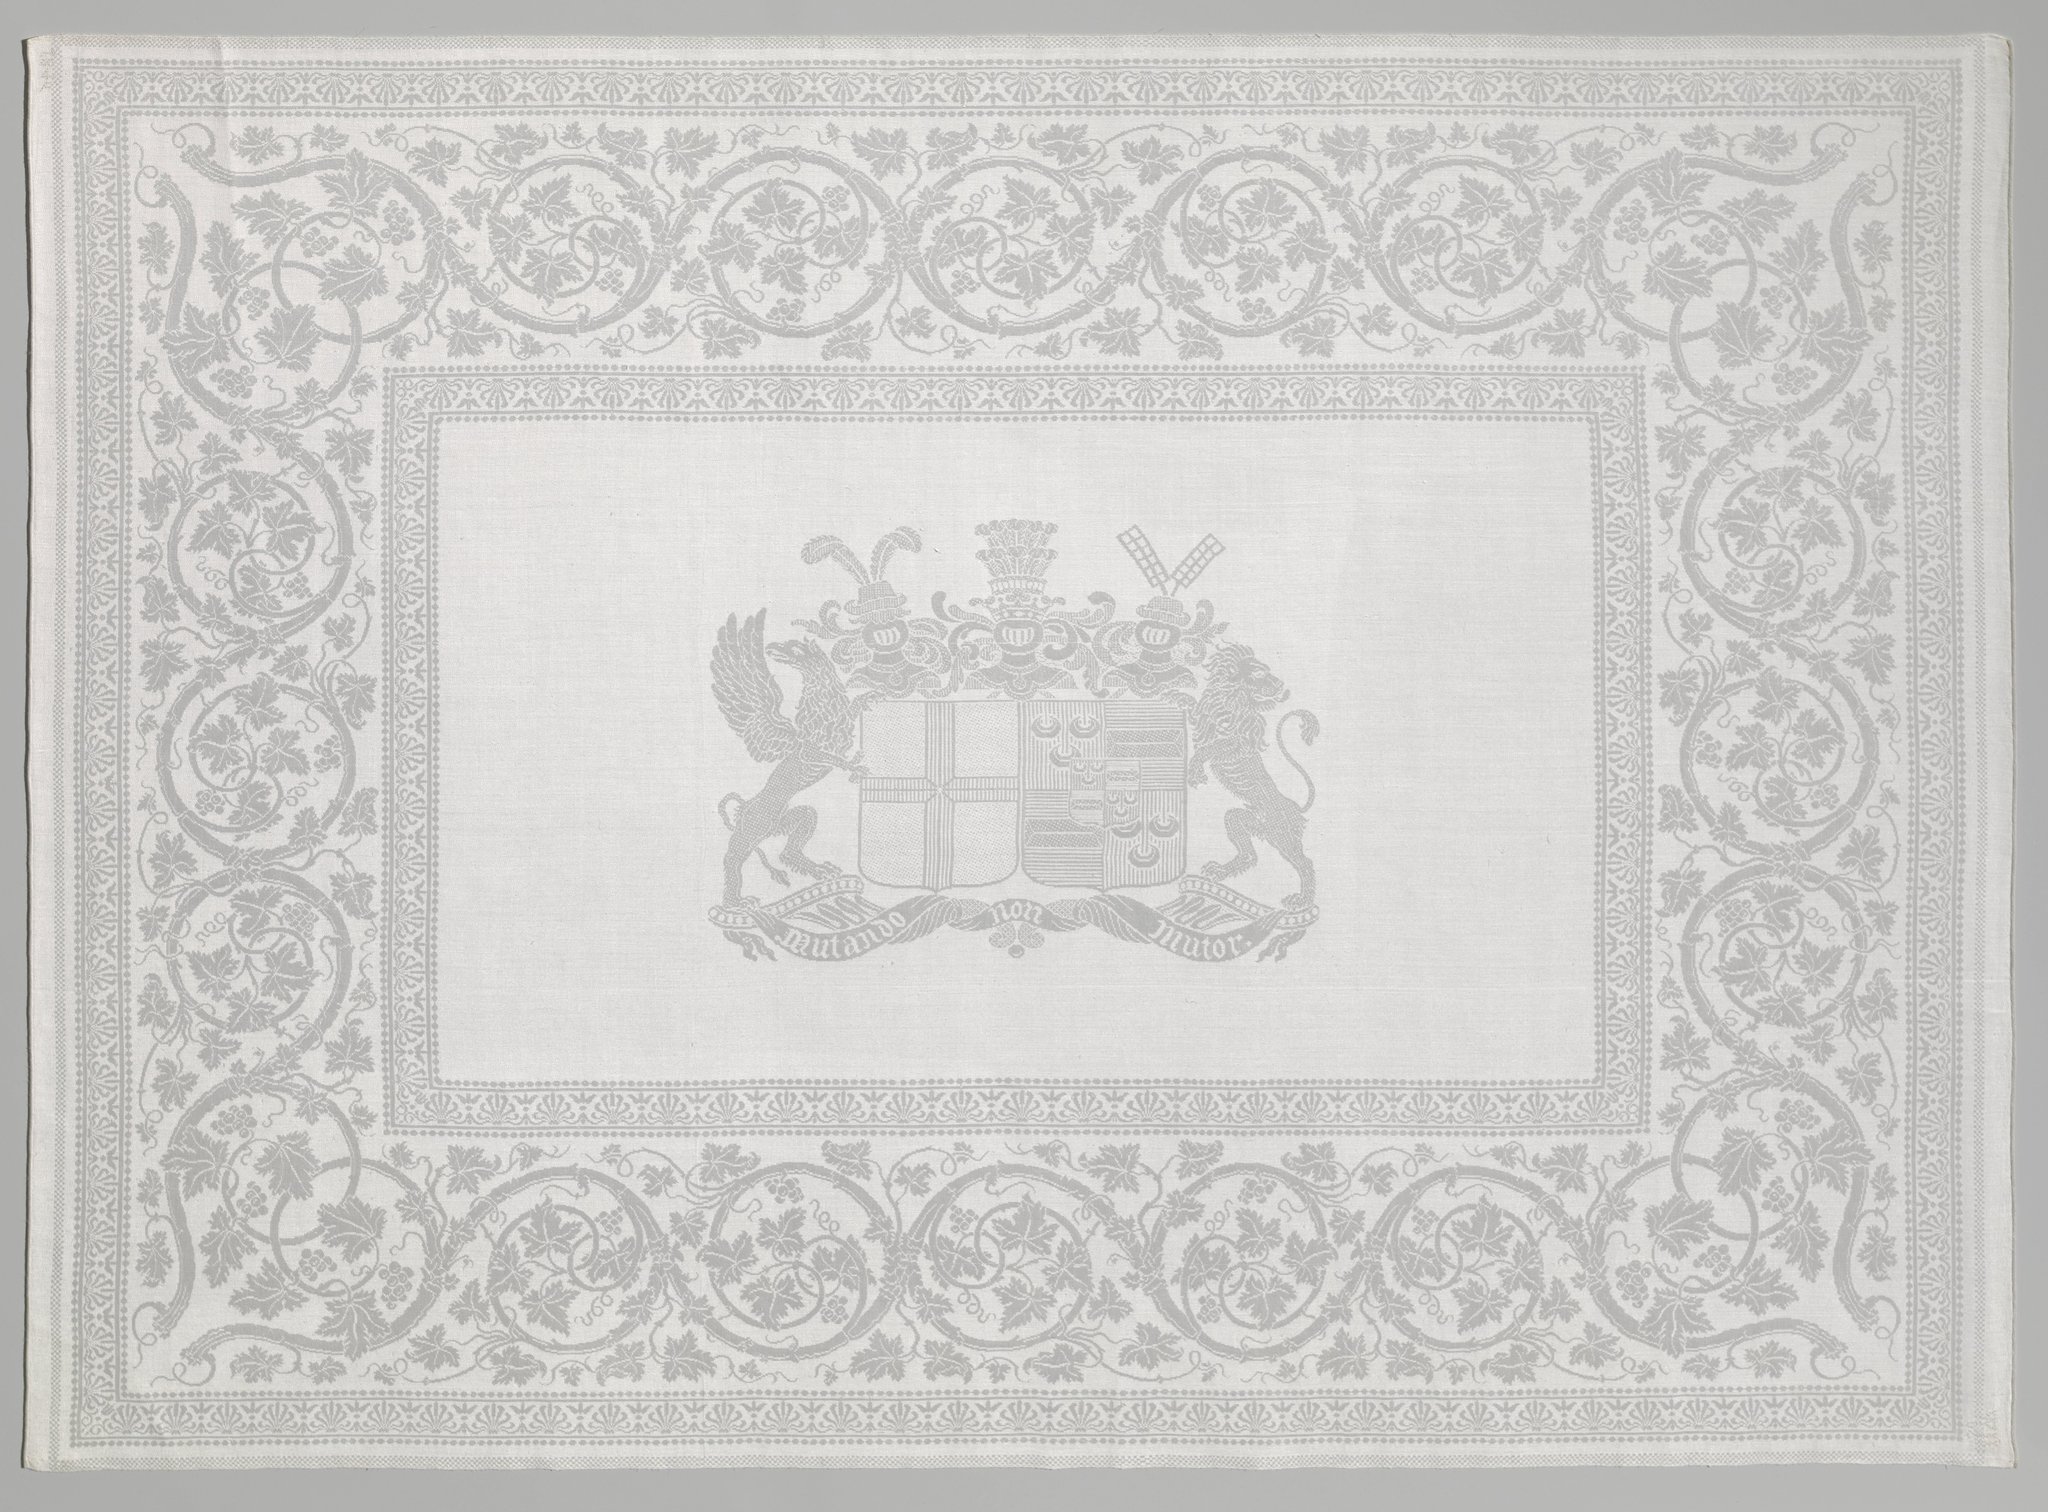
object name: napkin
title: Servet van linnendamast met wapens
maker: p.c. van de ven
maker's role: damastwever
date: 1846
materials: linen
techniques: damask, weave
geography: boxtel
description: Wit linnendamast servet met patroon van wapens van Heeckeren en van Wassenaer, merk kroon HW 36 en 1846.